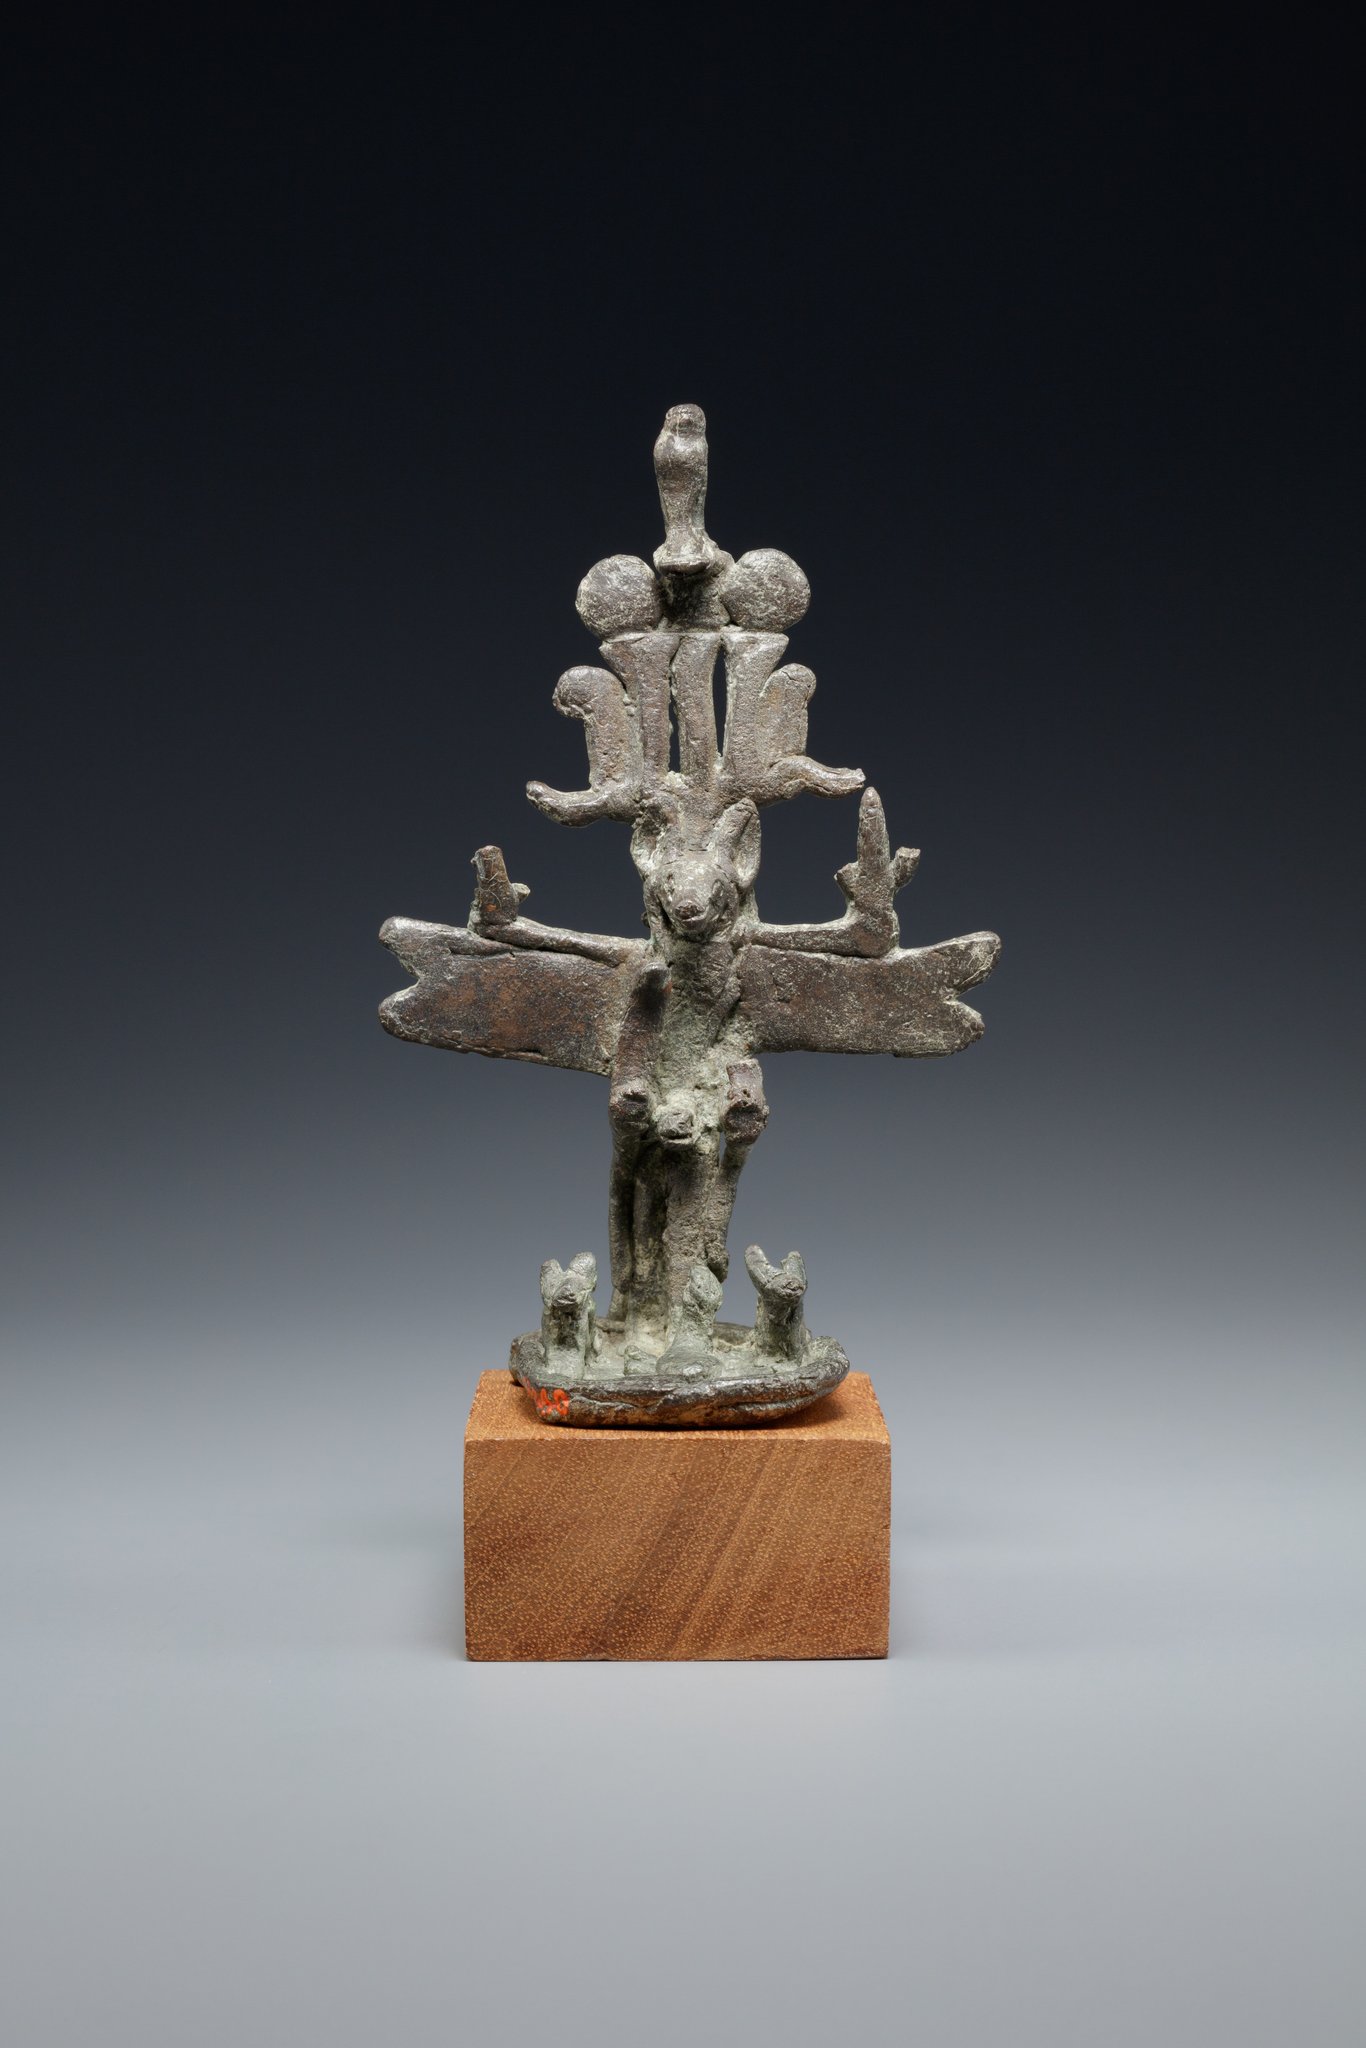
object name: figurine group, animal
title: Figurine group, animals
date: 688-525 BCE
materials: bronze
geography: egypt